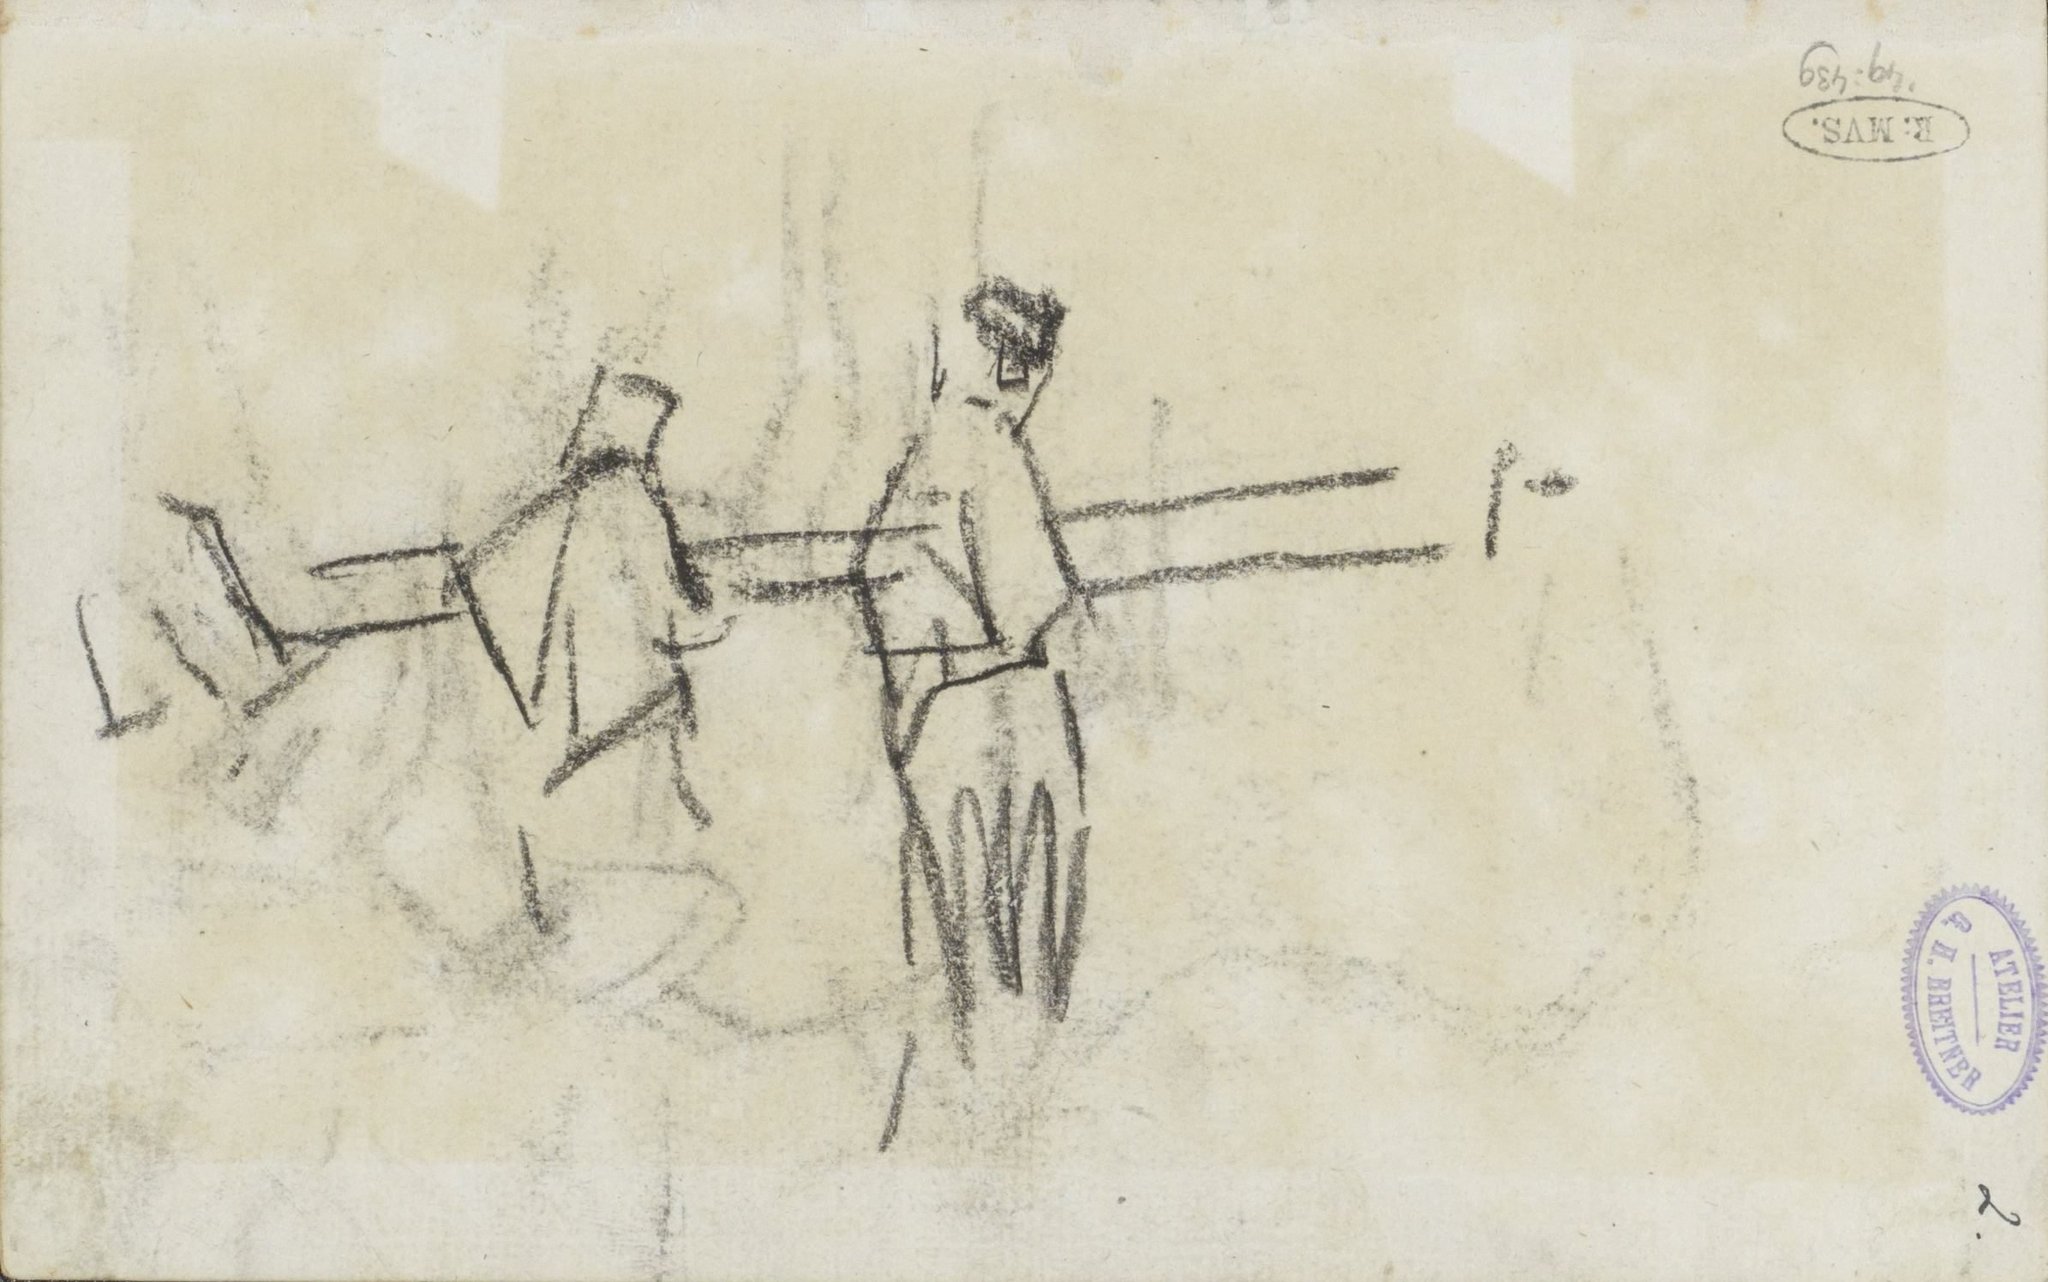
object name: drawing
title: Drie mannen dragen een paal, mogelijk een heipaal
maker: george hendrik breitner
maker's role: draughtsman, painter, print maker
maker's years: 1857-1923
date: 1906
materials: chalk, paper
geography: amsterdam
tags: carrying something, building activities (+ labourers ~ crafts, industries, agriculture), adult man (+ standing)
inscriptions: collector's mark: Lugt 2228, workshop stamp: Lugt 291d